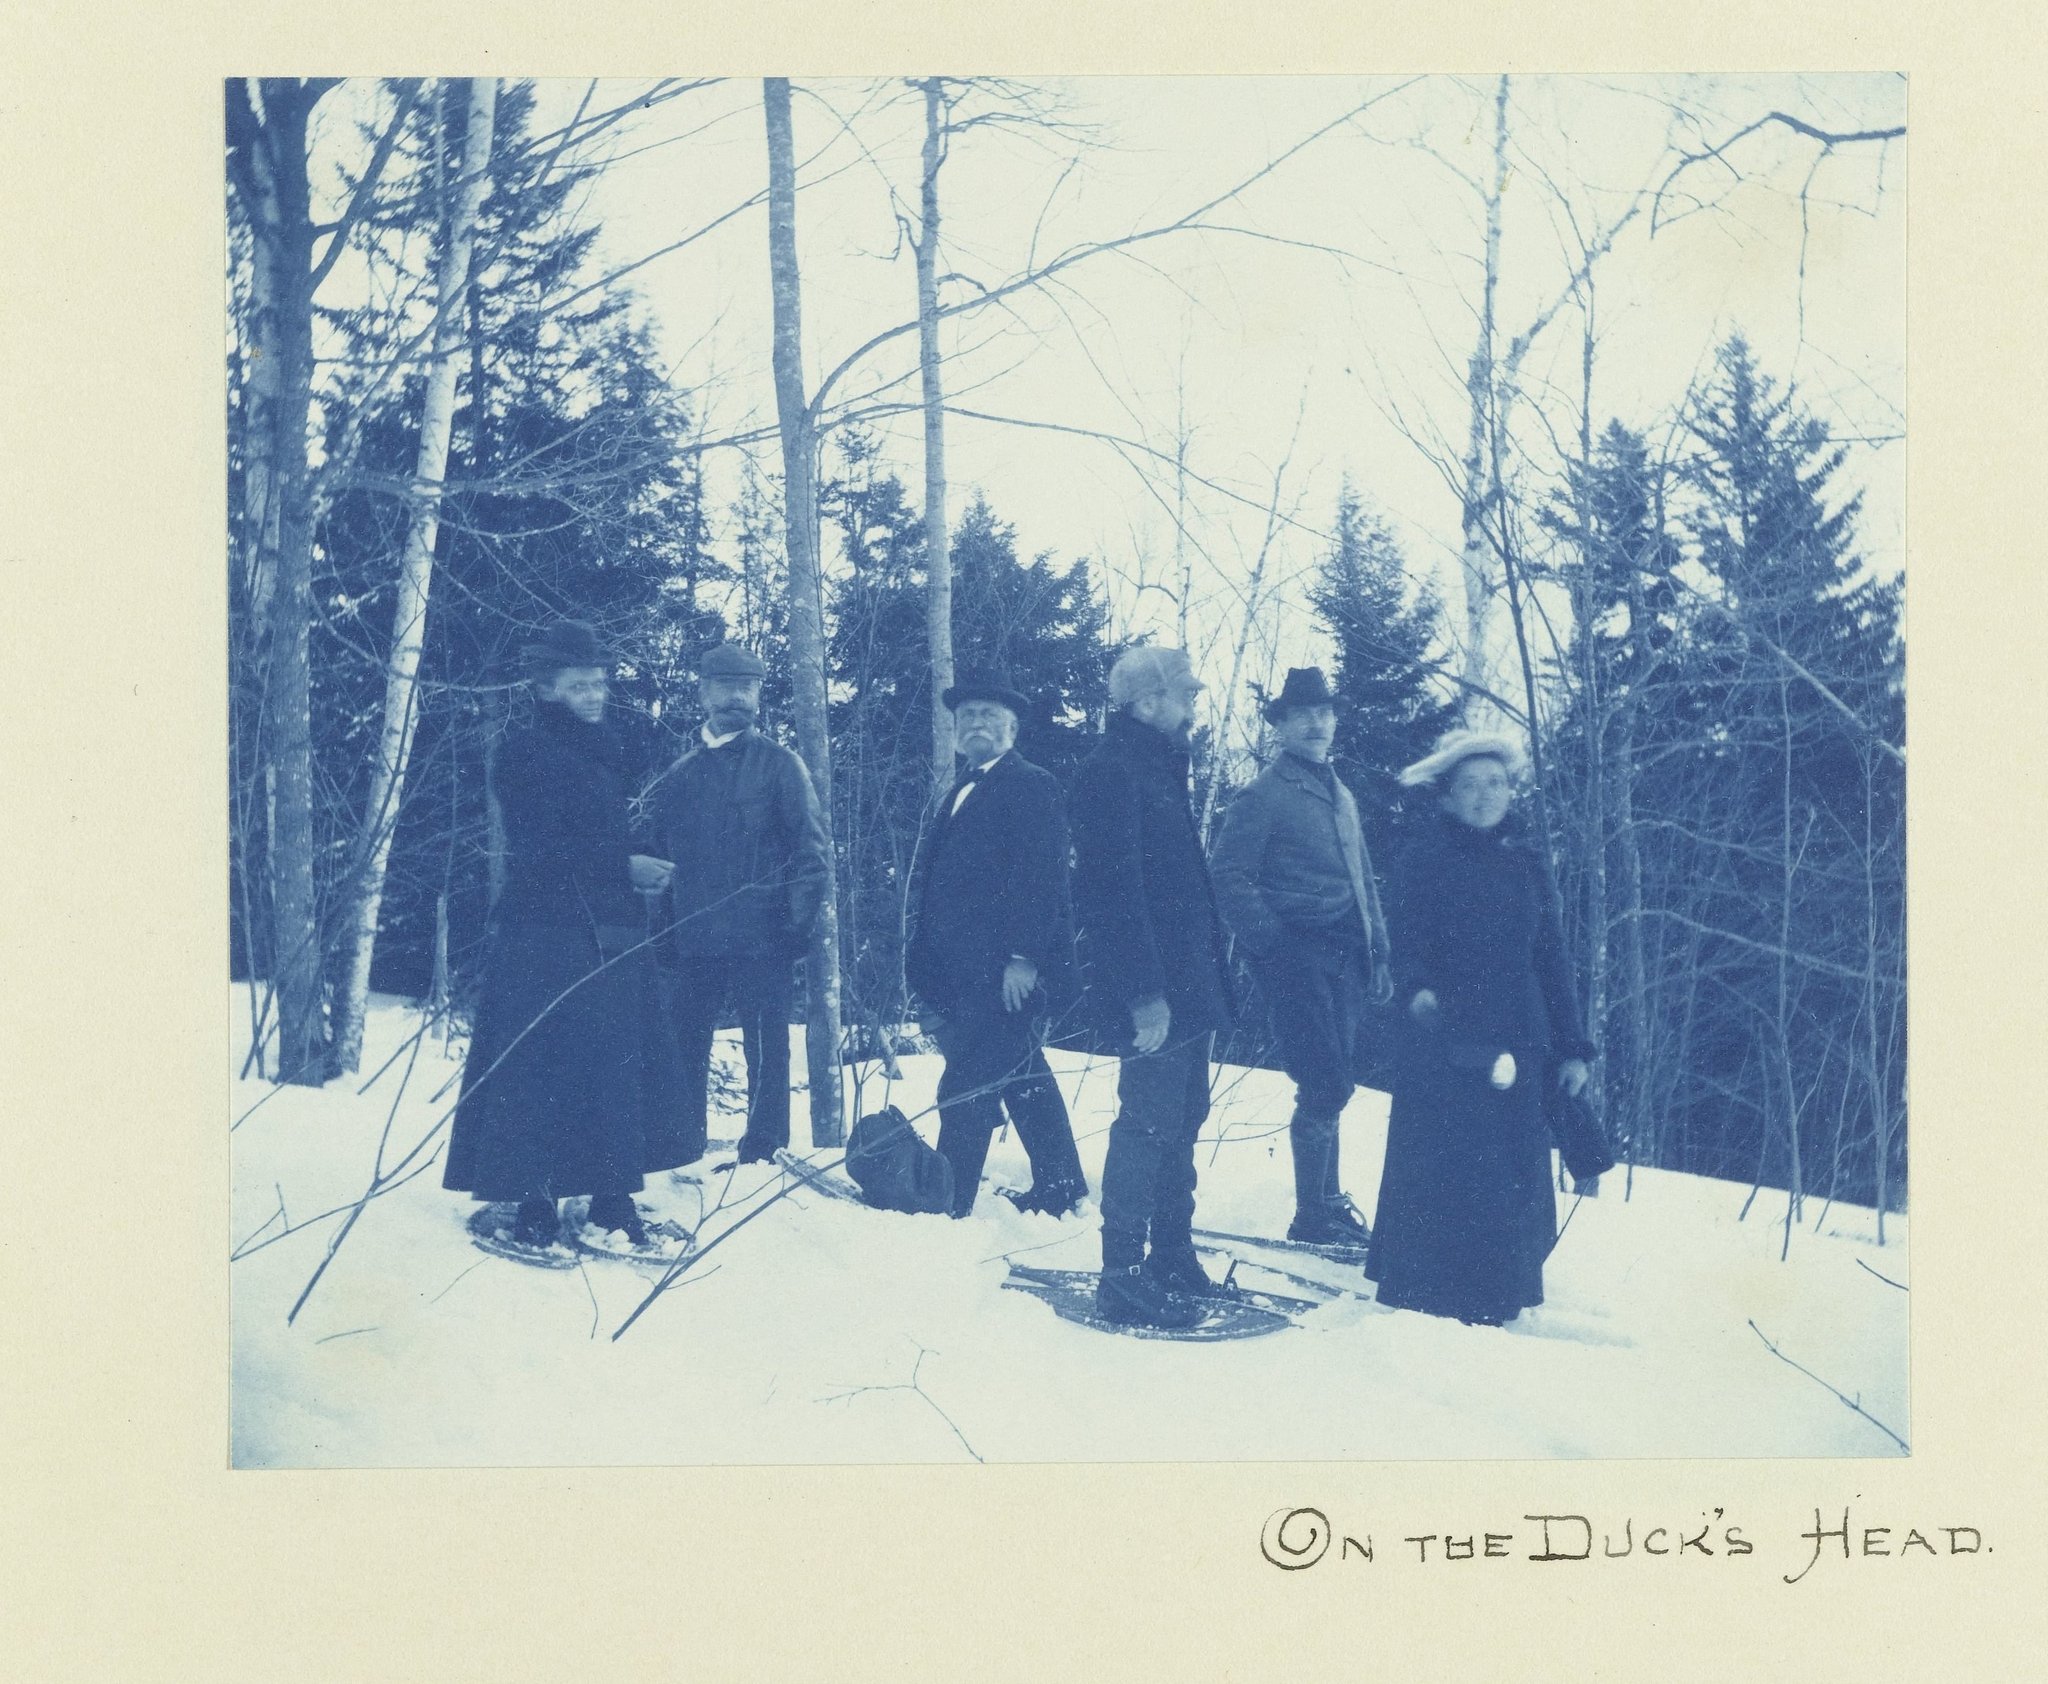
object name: photograph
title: Landschap in de sneeuw: gezelschap op the Duck's Head, NH, Verenigde Staten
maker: charlotte m. endicott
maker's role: fotograaf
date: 1899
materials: photographic support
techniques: cyanotype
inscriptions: title: ‘ON THE DUCK'S HEAD./ FEB. 19. 1899.’